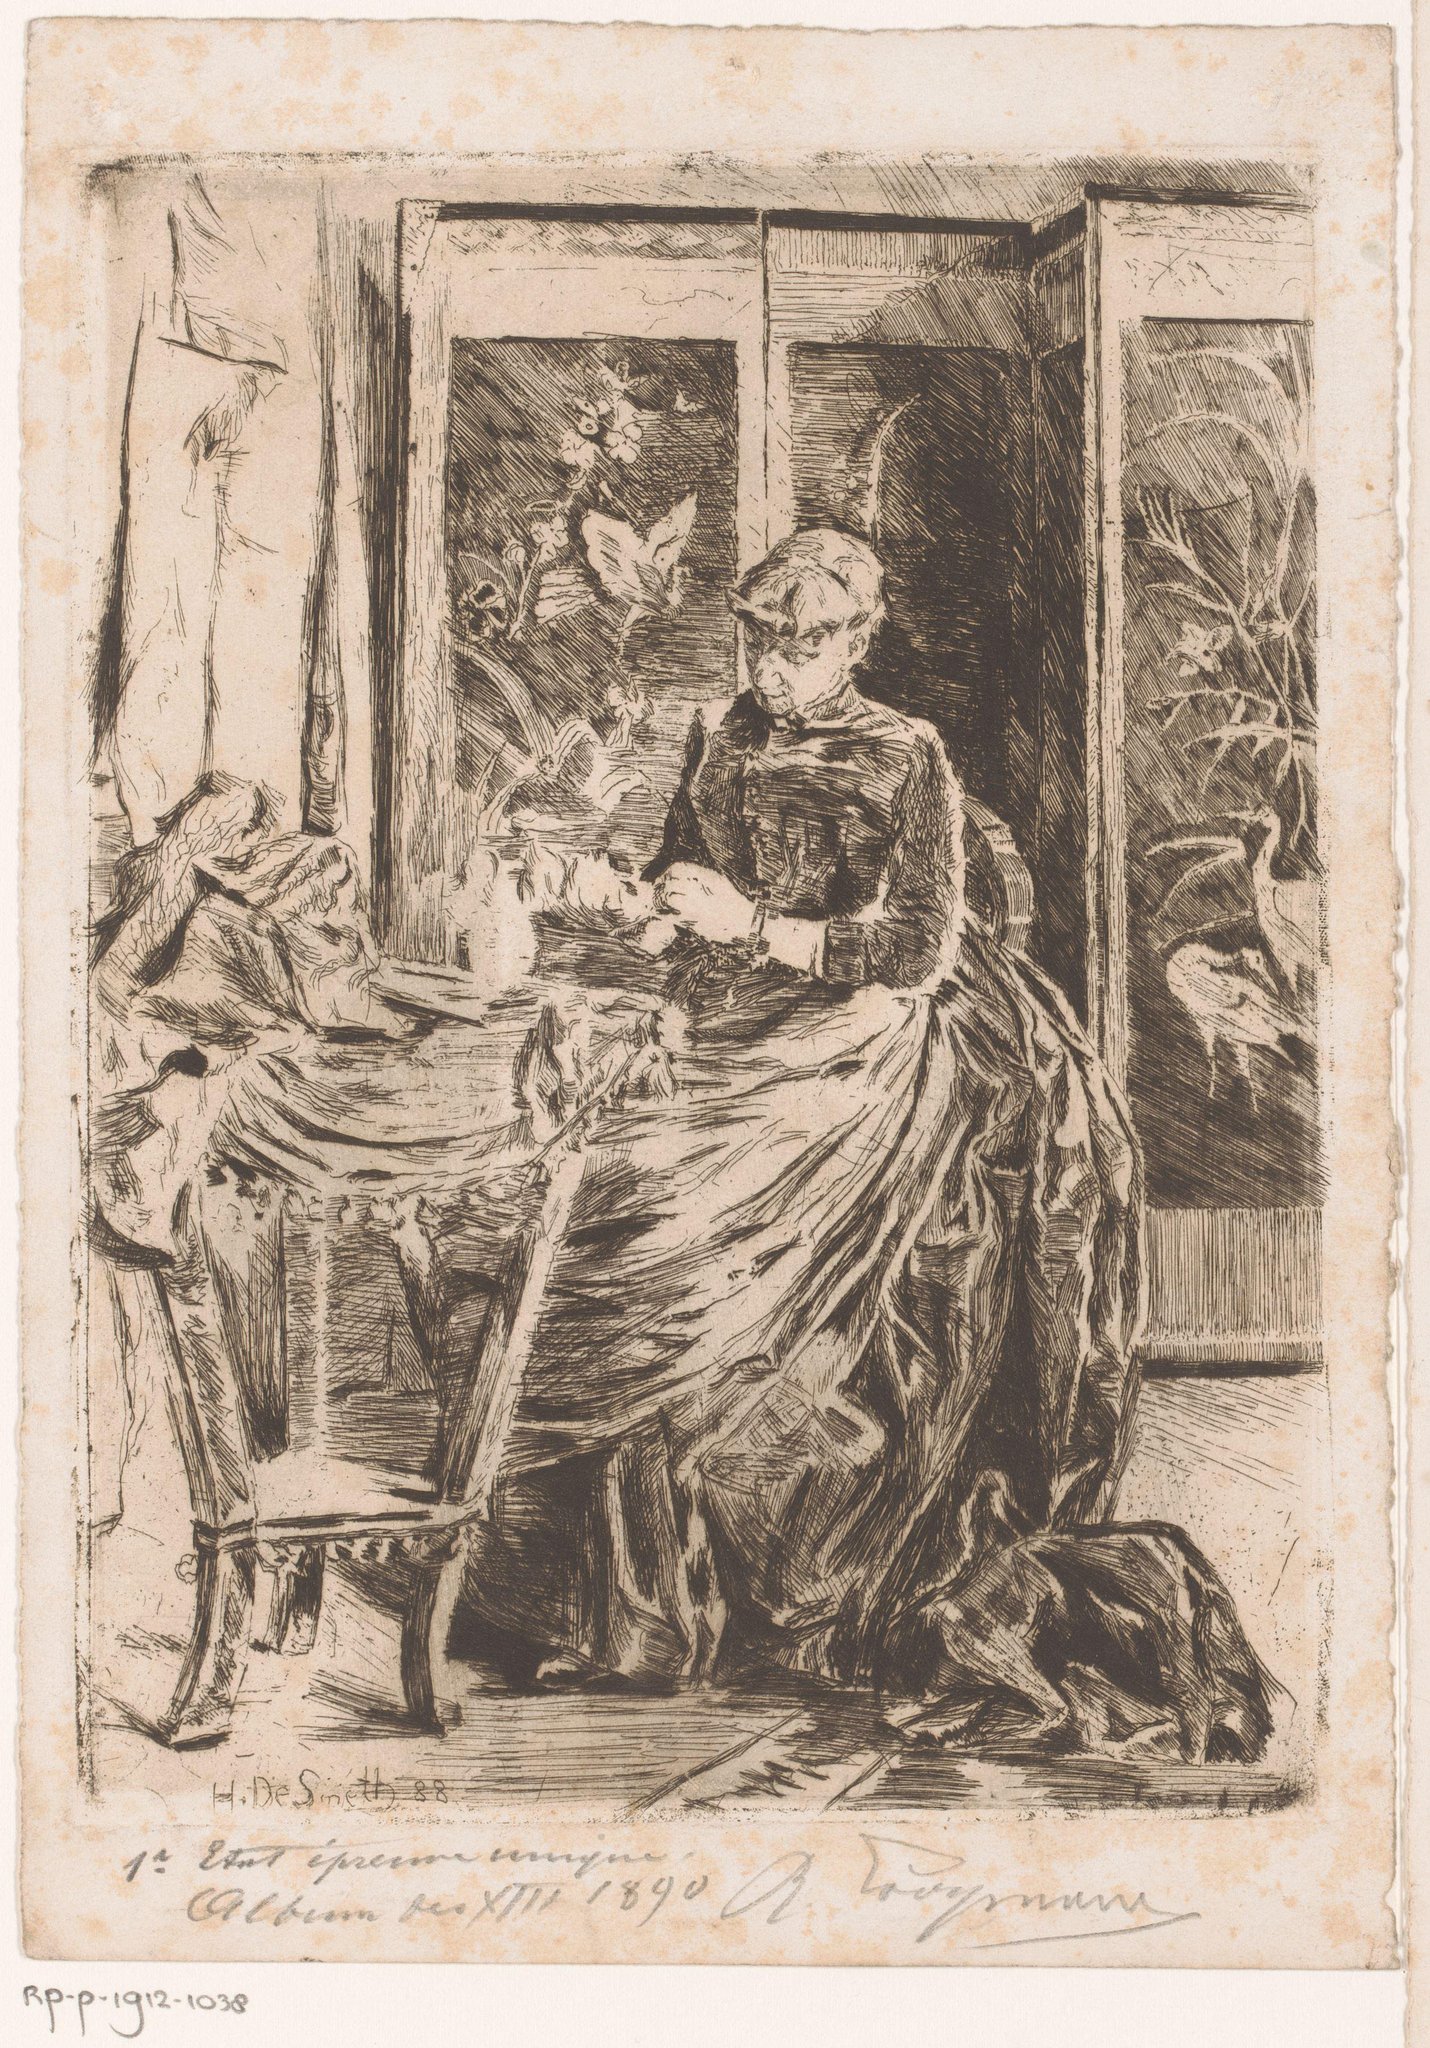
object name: print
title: Handwerkende vrouw in een interieur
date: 1890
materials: paper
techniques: drypoint, etching, intaglio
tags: sewing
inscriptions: collector's mark: Lugt 2228, annotation: ‘1e Etat épreuve unique Album des XIII 1890’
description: Latere staat van deze prent in de suite XIII, 1890. Dit was een periodieke uitgave van de kunstenaarskring Cercle des XIII.